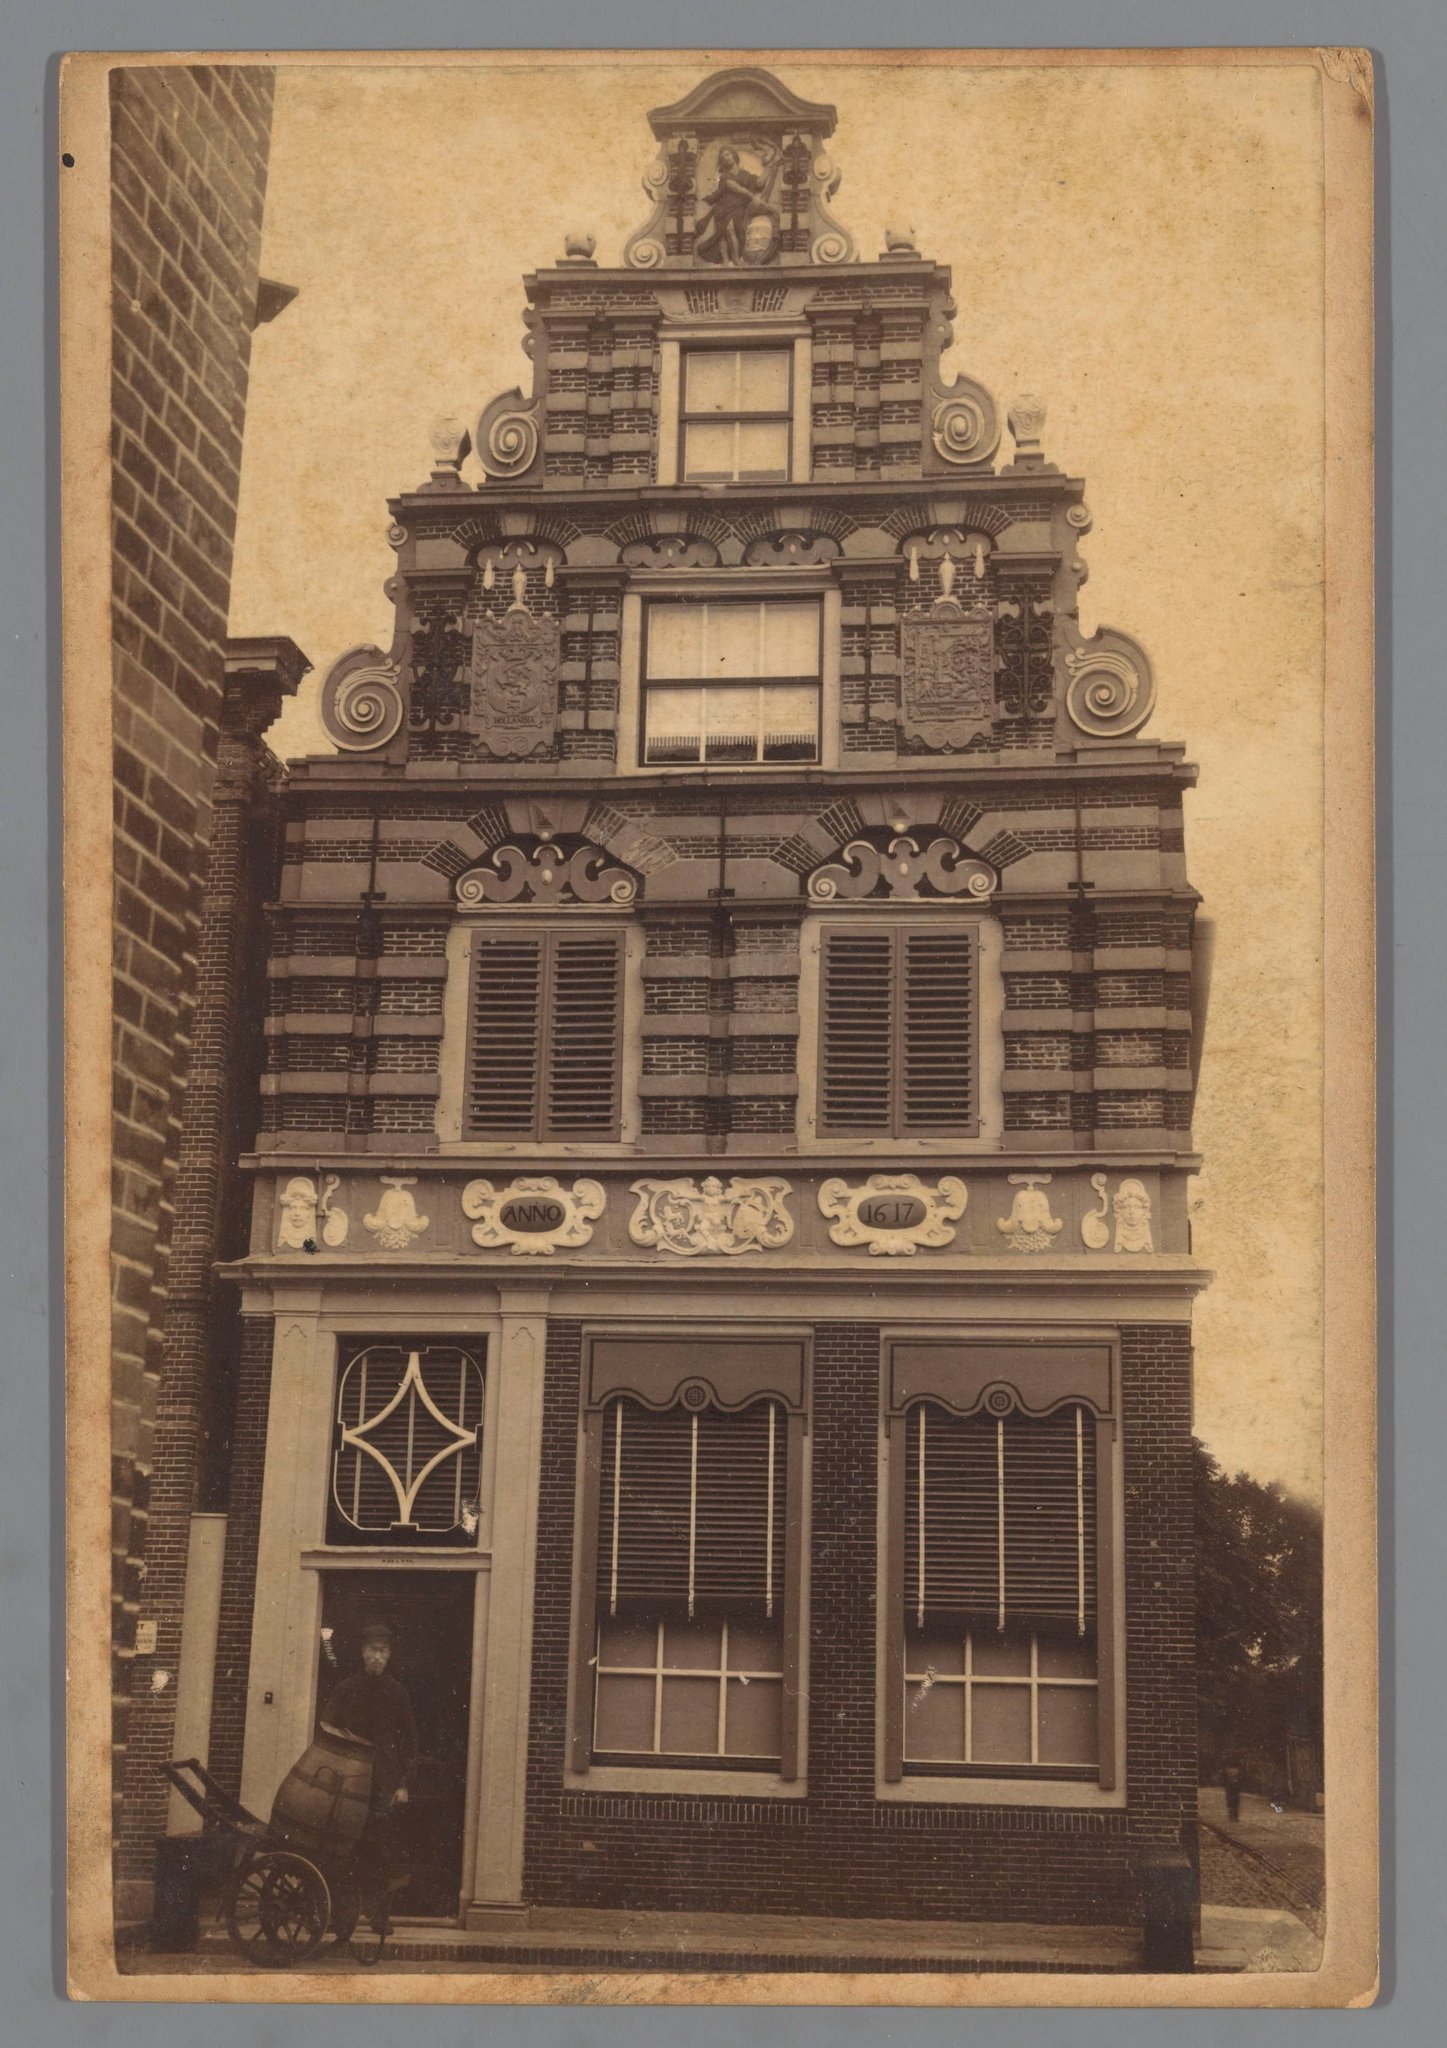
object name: cabinet photograph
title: Gezicht op een huis in Enkhuizen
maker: Anonymous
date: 1850-1900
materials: cardboard, photographic support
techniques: albumen print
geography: enkhuizen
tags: front façade, enkhuizen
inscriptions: annotation: ‘Enkhuizen’